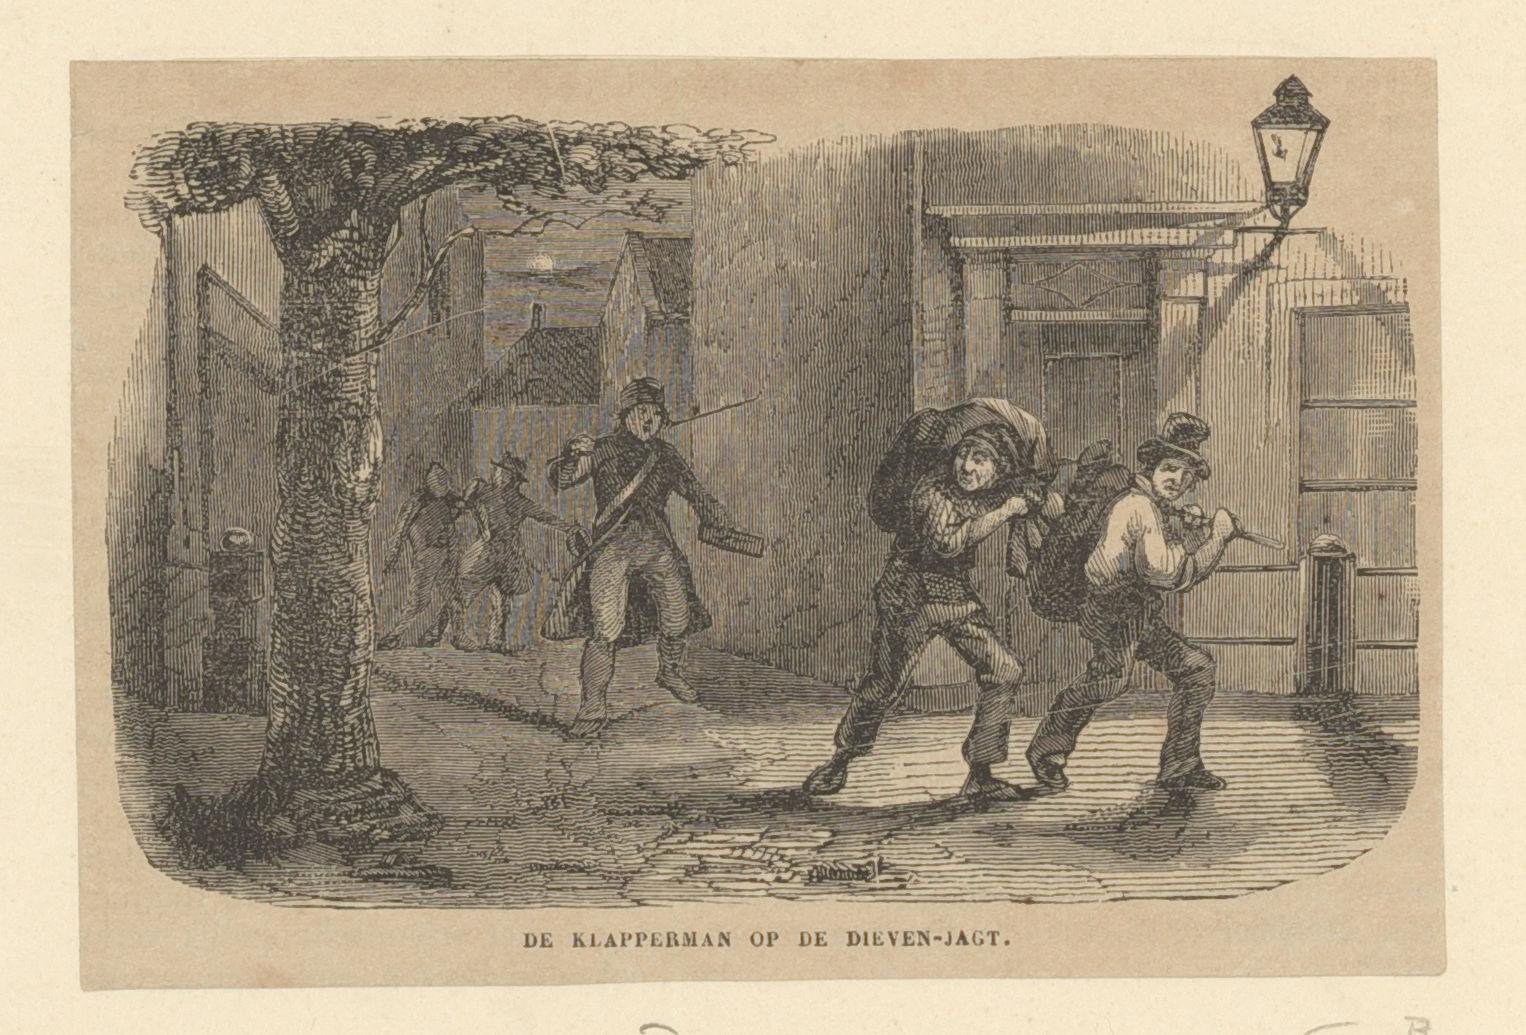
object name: print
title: De klapperman op de dieven-jagt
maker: Anonymous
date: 1849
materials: paper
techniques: letterpress printing, engraving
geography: amsterdam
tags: guard duty, keeping sentry, night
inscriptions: stamp, collector's mark: Lugt 1641, stamp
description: De klepperman of klapperman is een nachtwacht die in de nacht over straat loopt met een klep en riep om hoe laat het was. Onderwerpsrubrieken binnen de Atlas Zeden en Gewoonten: Handel, Nijverheid en verkeer, Beroep en bedrijf, Mannelijk, Klapperman, omroeper, nachtwaker.